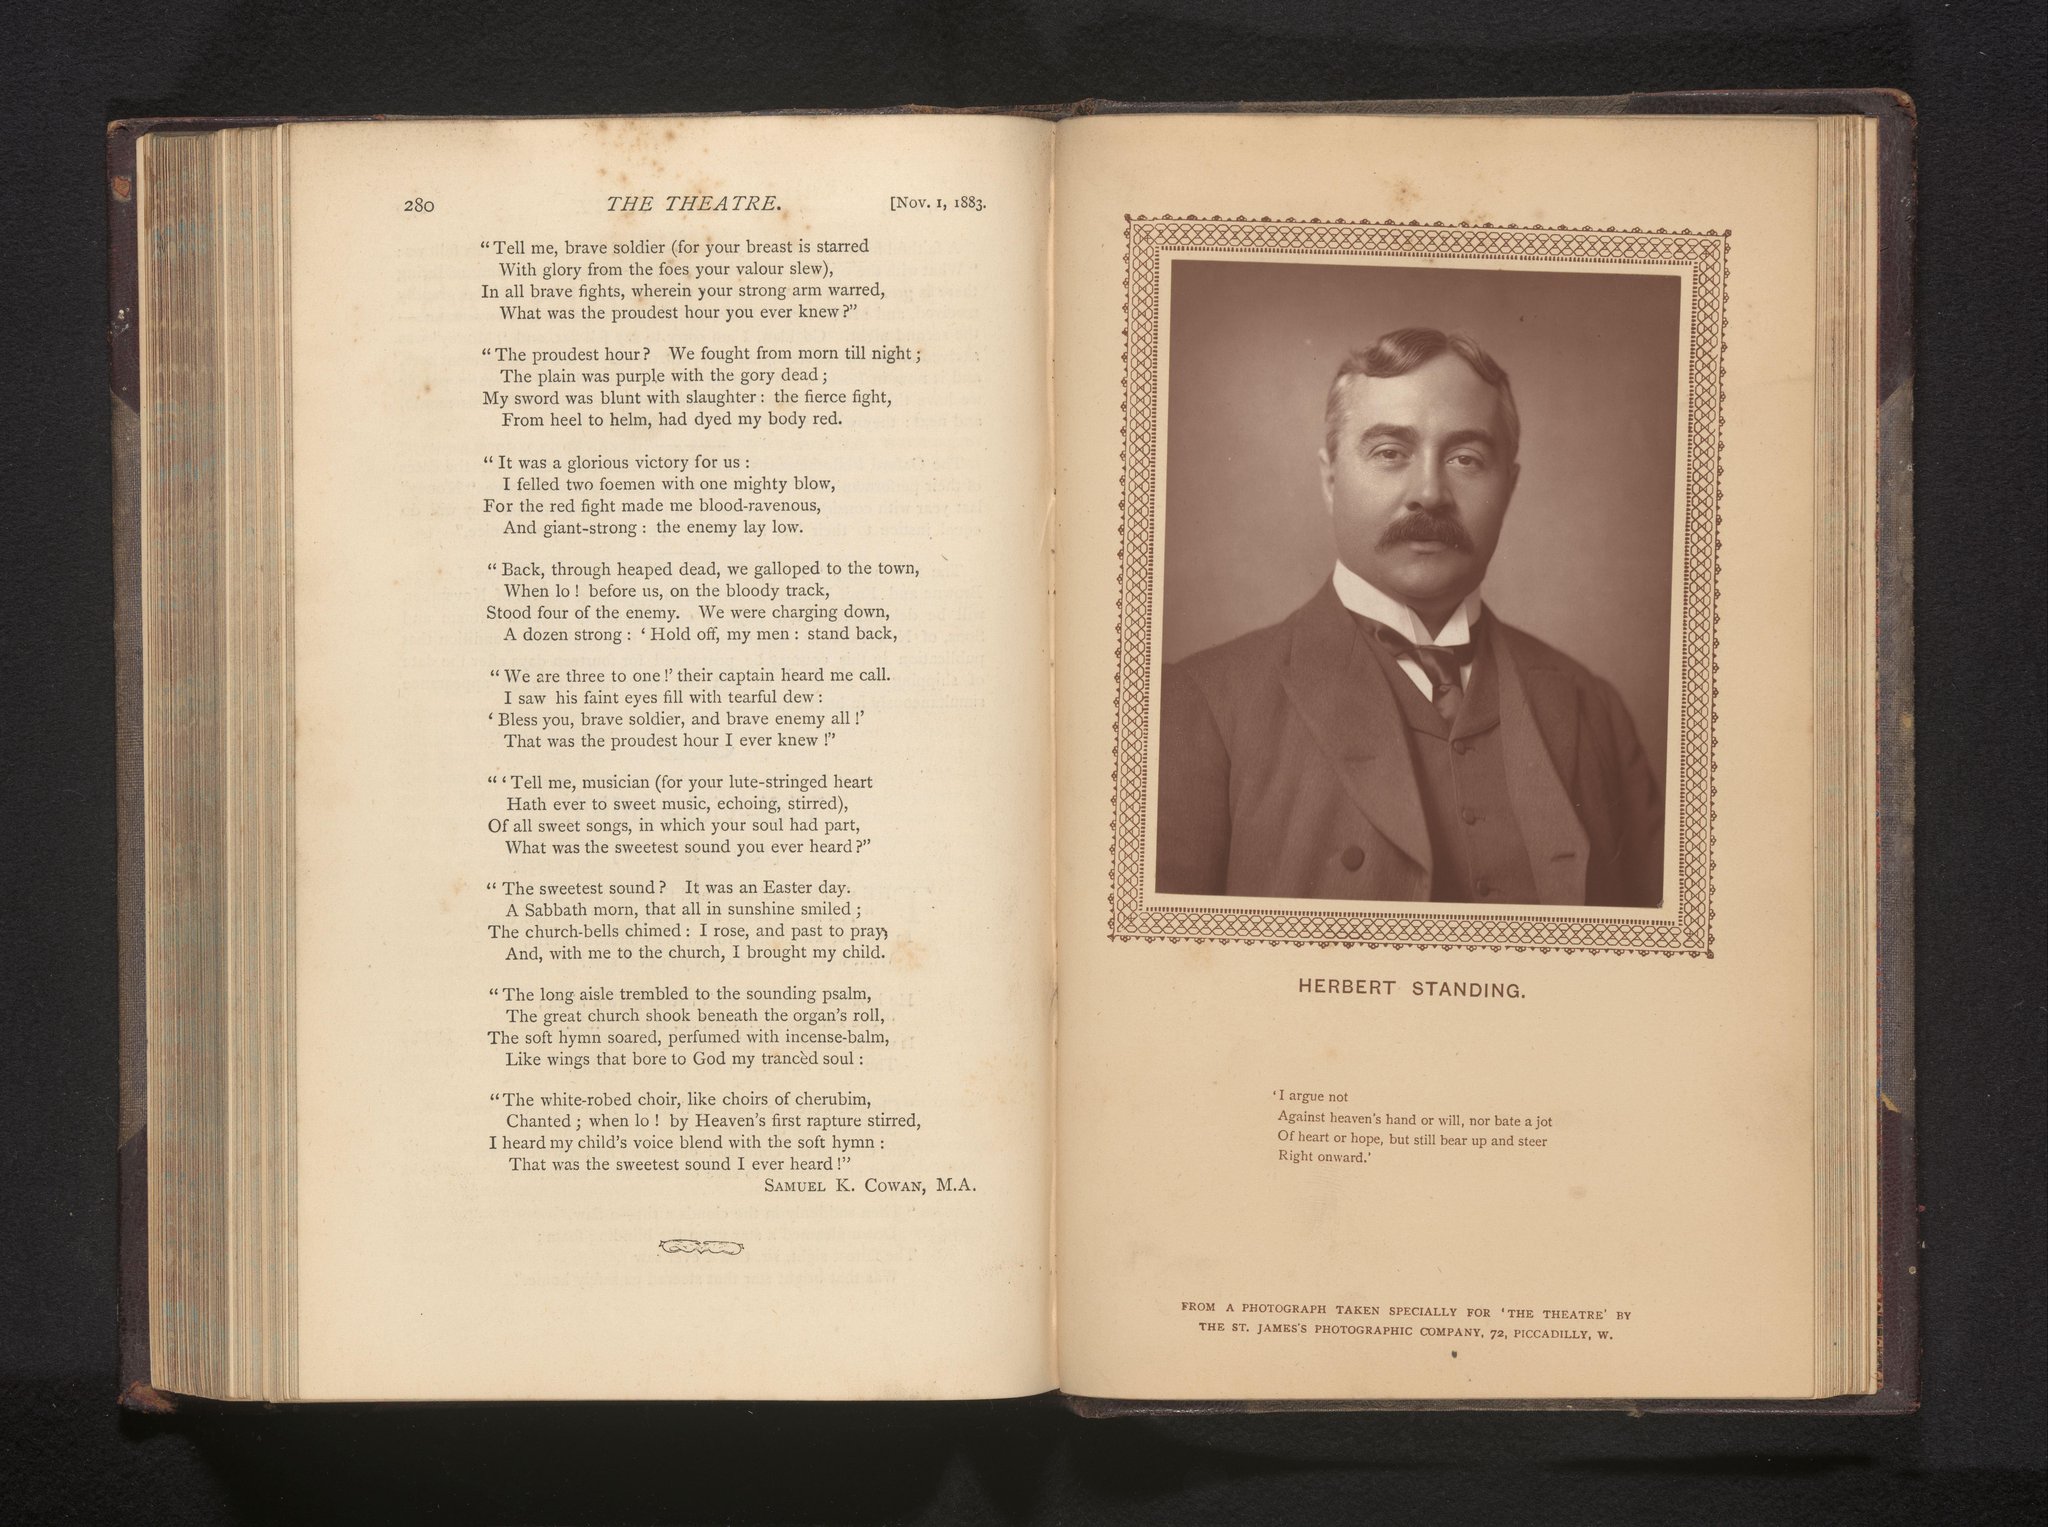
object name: photomechanical print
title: Portret van Herbert Standing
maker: Anonymous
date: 1878-1883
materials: paper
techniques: woodburytype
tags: adult man, historical persons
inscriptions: inscription: ‘'I argue not/ Against heaven's hand or will, nor bate a jot/ of heart or hope, but still bear up and steer/ right onward.'’